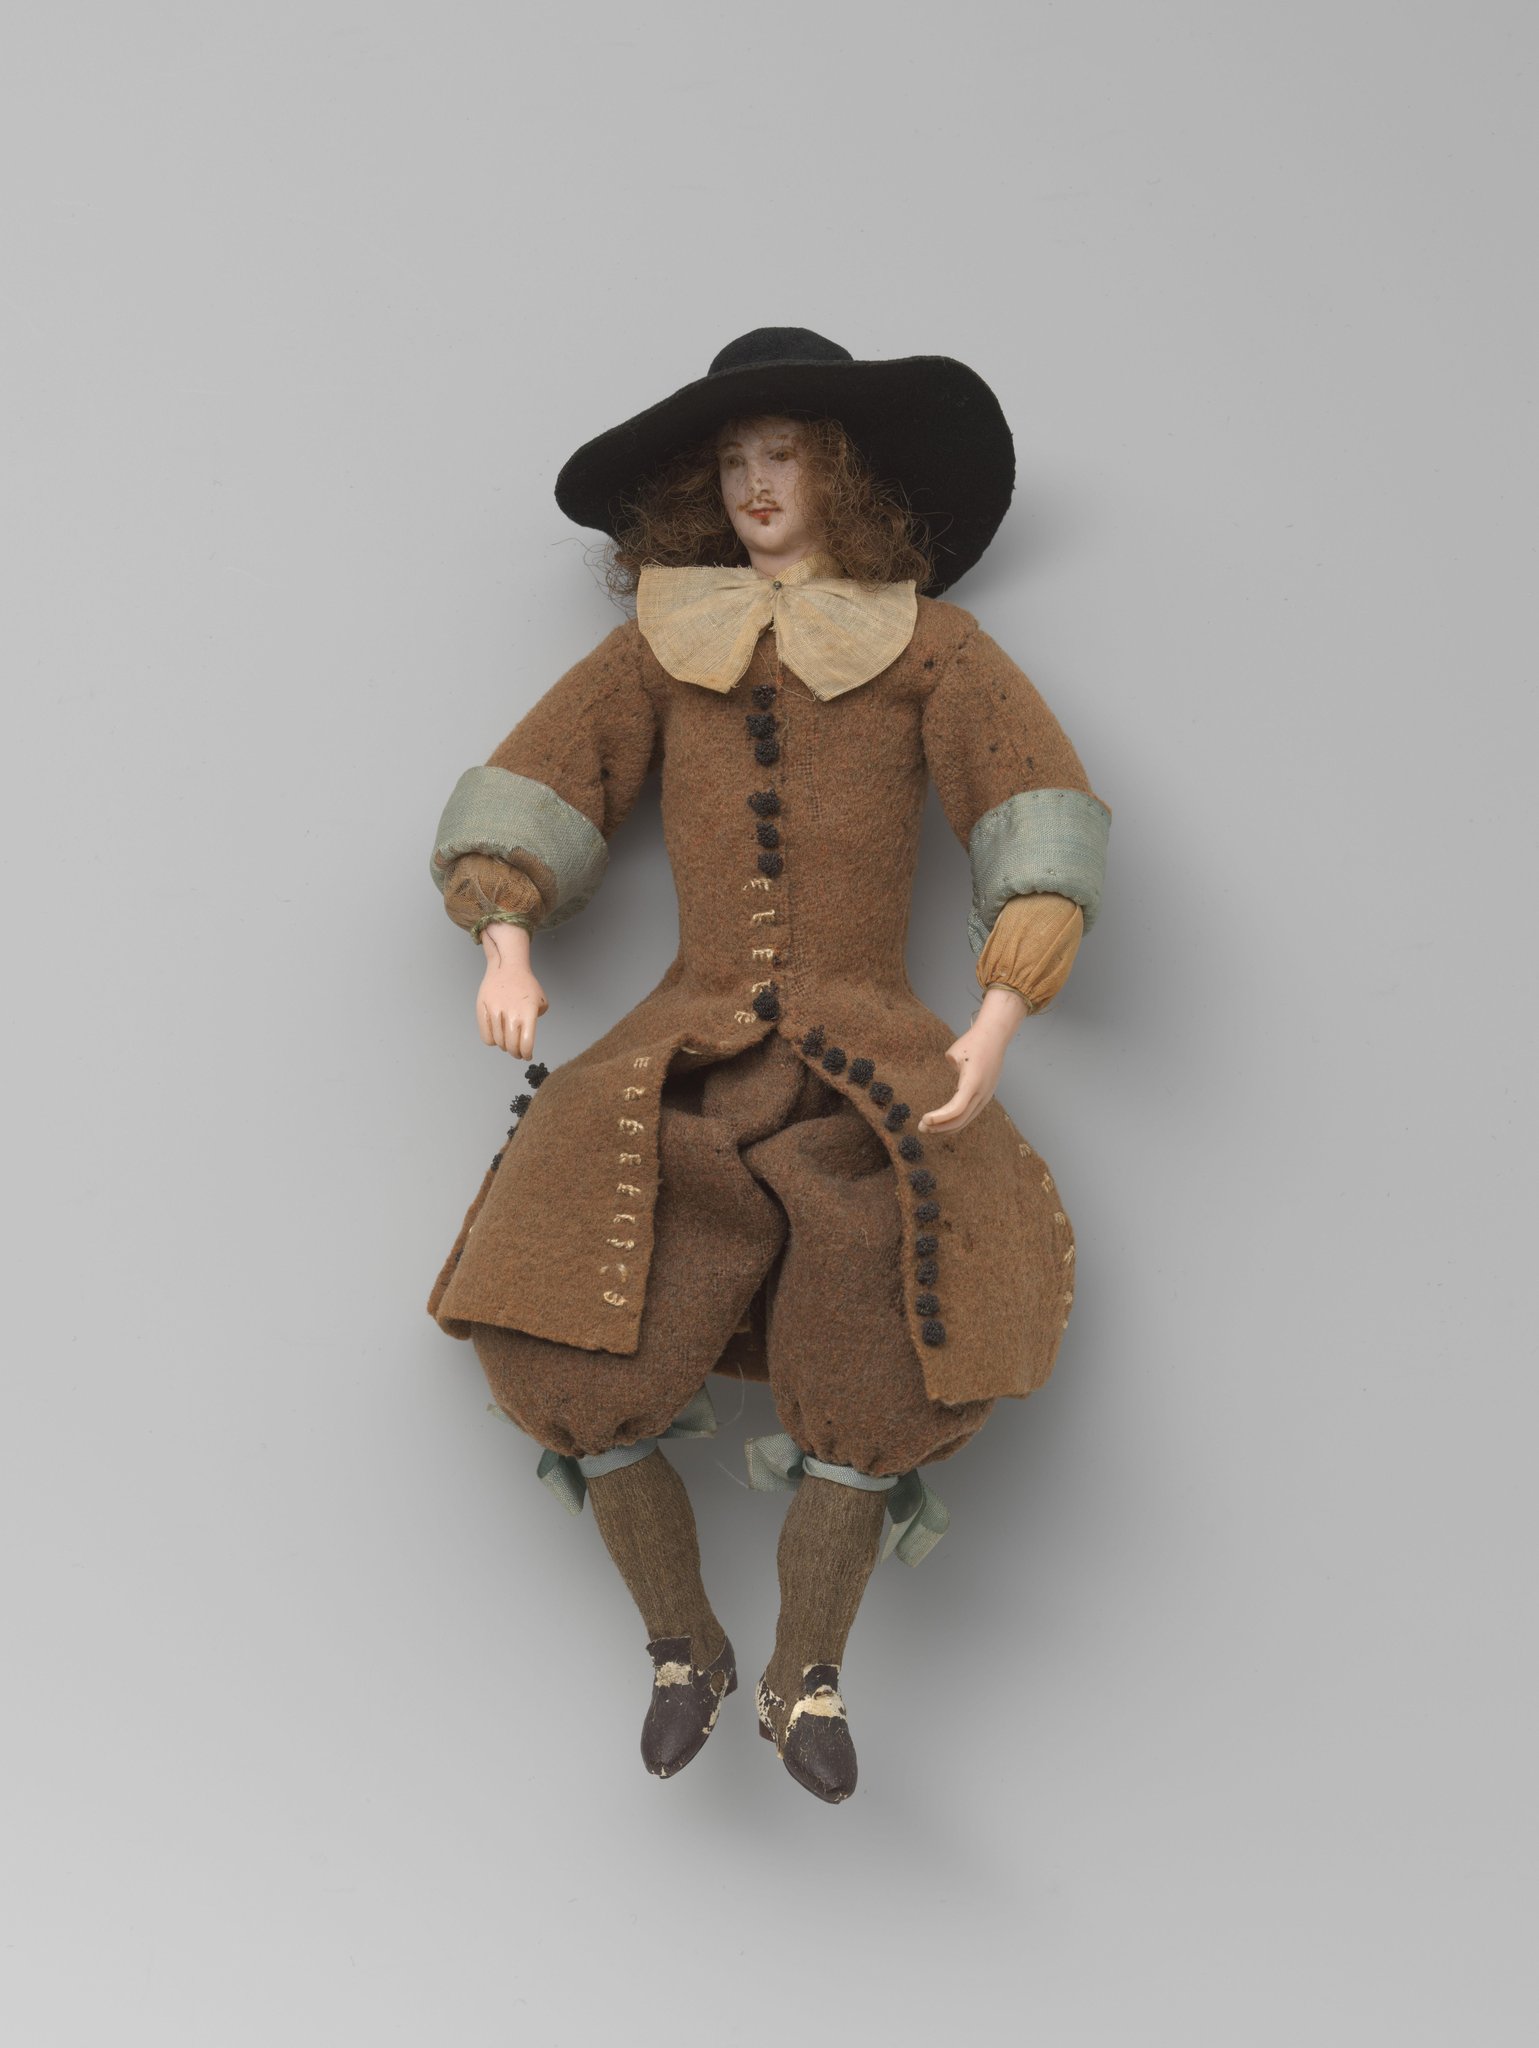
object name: toy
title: Pop, voorstellende een heer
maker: Anonymous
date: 1676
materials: hair, linen, metal thread, silk, fiber, wax, wool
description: Pop, voorstellende een heer, gekleed in een tot de knie reikende justaucorps van gemêleerd bruin laken, waaronder een kniebroek van dezelfde stof. Op zijn hoofd een zwart vilten hoed.